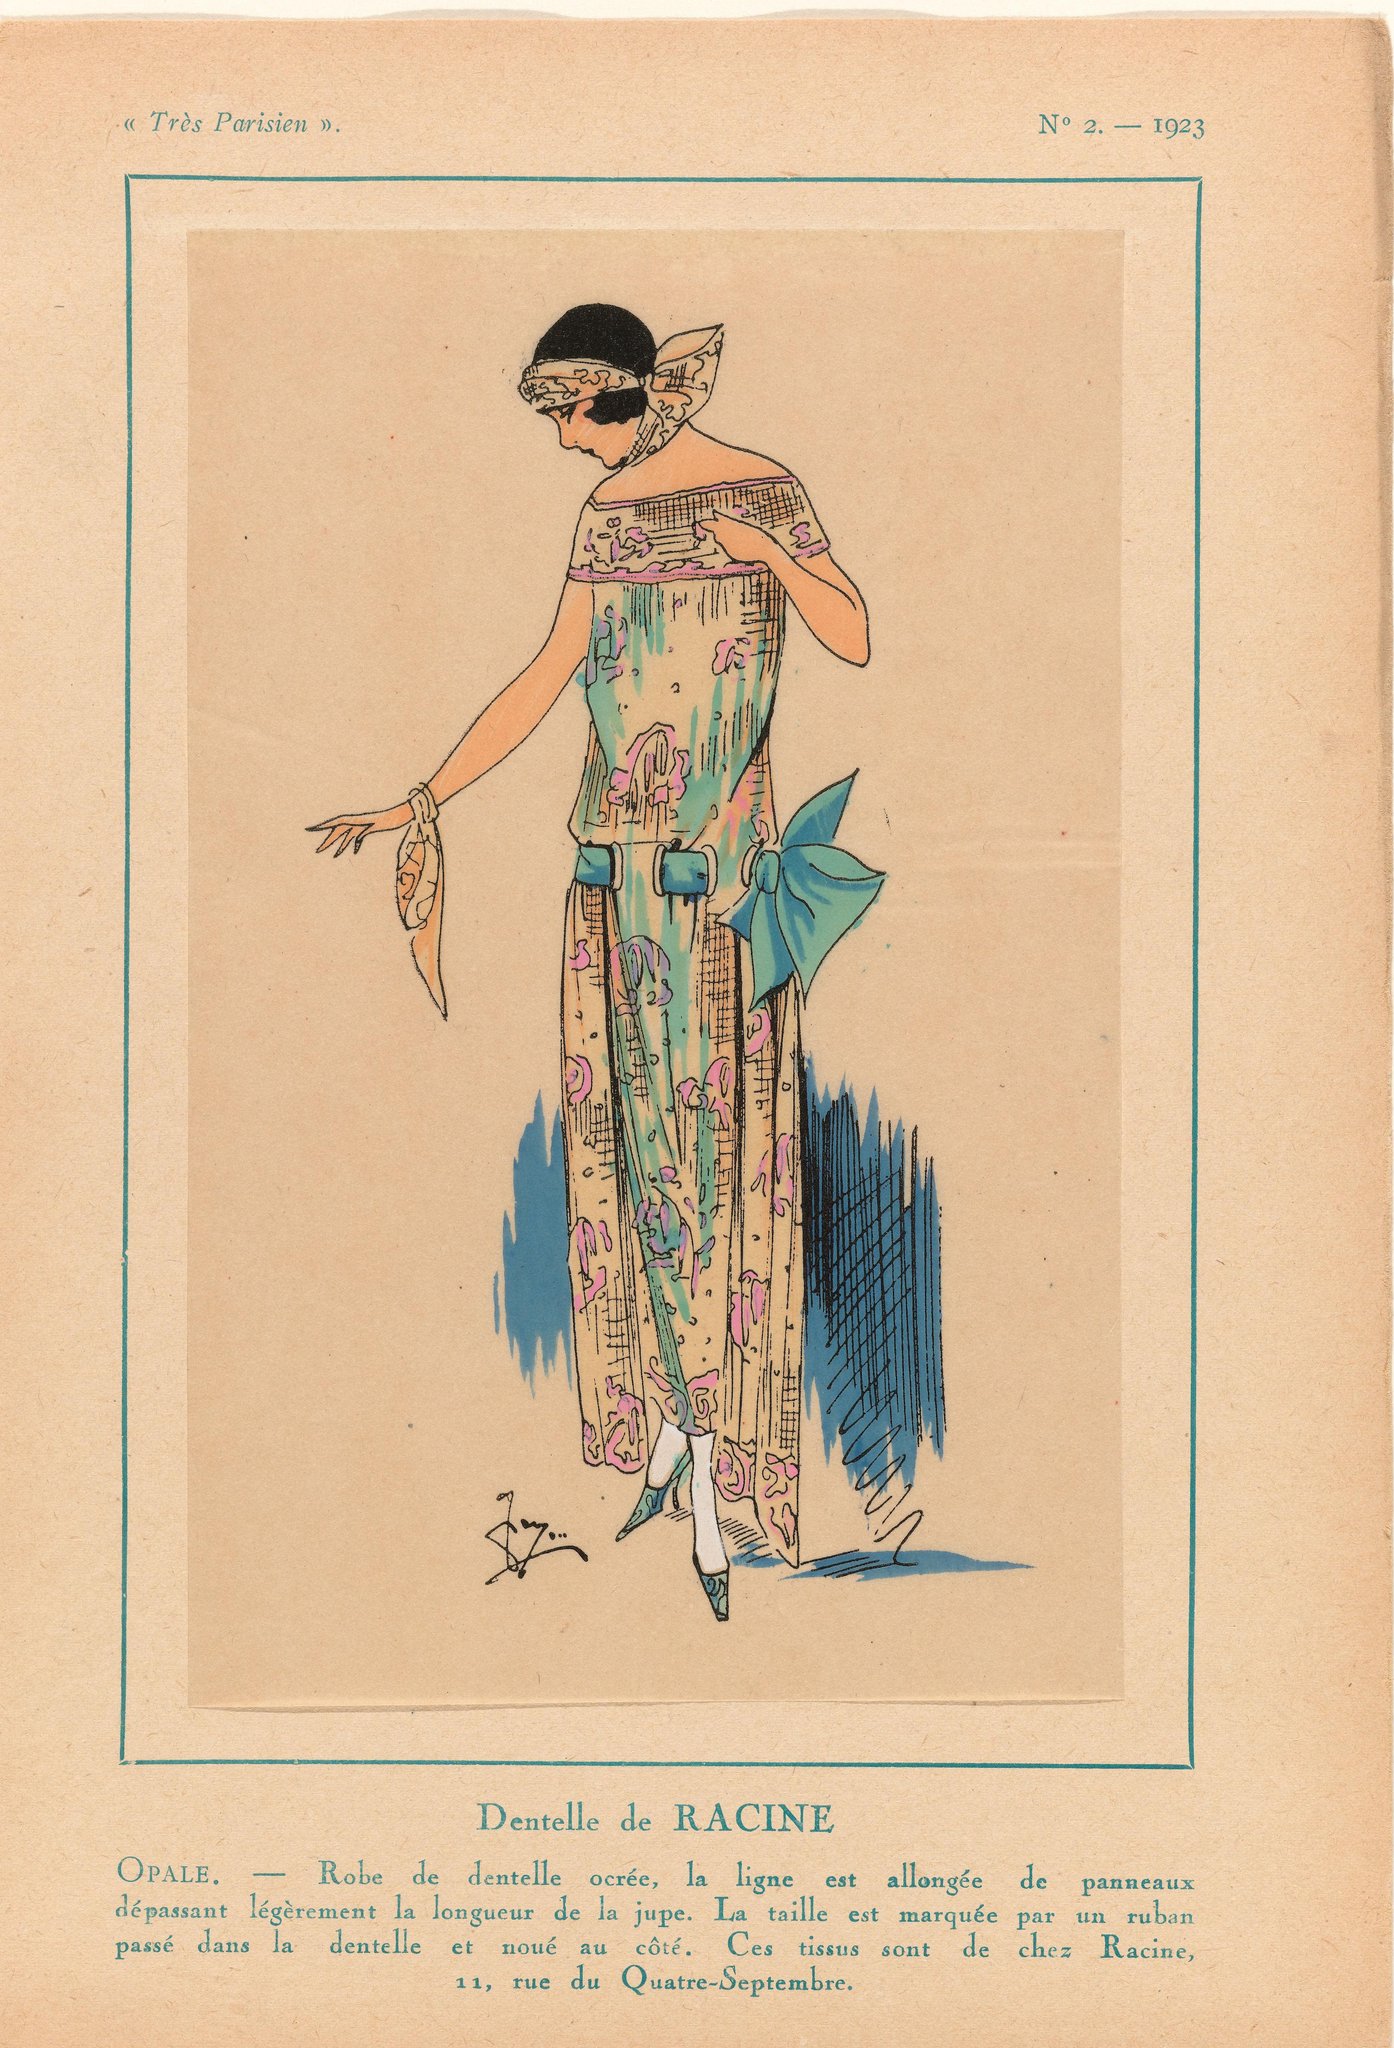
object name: fashion print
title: Très Parisien, 1923, No. 2: Dentelle de RACINE...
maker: g-p. joumard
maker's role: publisher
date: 1923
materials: paper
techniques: hand coloring, letterpress printing, lithography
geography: paris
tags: diadem, tiara (+ women's clothes), lace (+ women's clothes), dress, gown (+ lace used for clothes), fashion plates, dress, gown (+ women's clothes)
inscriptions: title: ‘Très Parisien / No 2. - 1923’, caption: ‘Dentelle de RACINE / OPALE. - Robe de dentelle ocrée, la ligne est allongée de panneaux dépassant légèrement la longueur de la jupe. La taille est marquée par un ruban passé dans la dentelle et noué au côté. Ces tissus sont de chez Racine, 11, rue du Quatre-Septembre.’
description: Kant van Racine. Jurk van okerkleurig kant, de lijn is verlengd met panden die iets langer zijn dan de rok. De taille wordt benadrukt door een lint die door het kant heen gaat en aan de zijkant is gestrikt. De stoffen zijn van Racine. Prent uit het modetijdschrift Très Parisien (1920-1936).